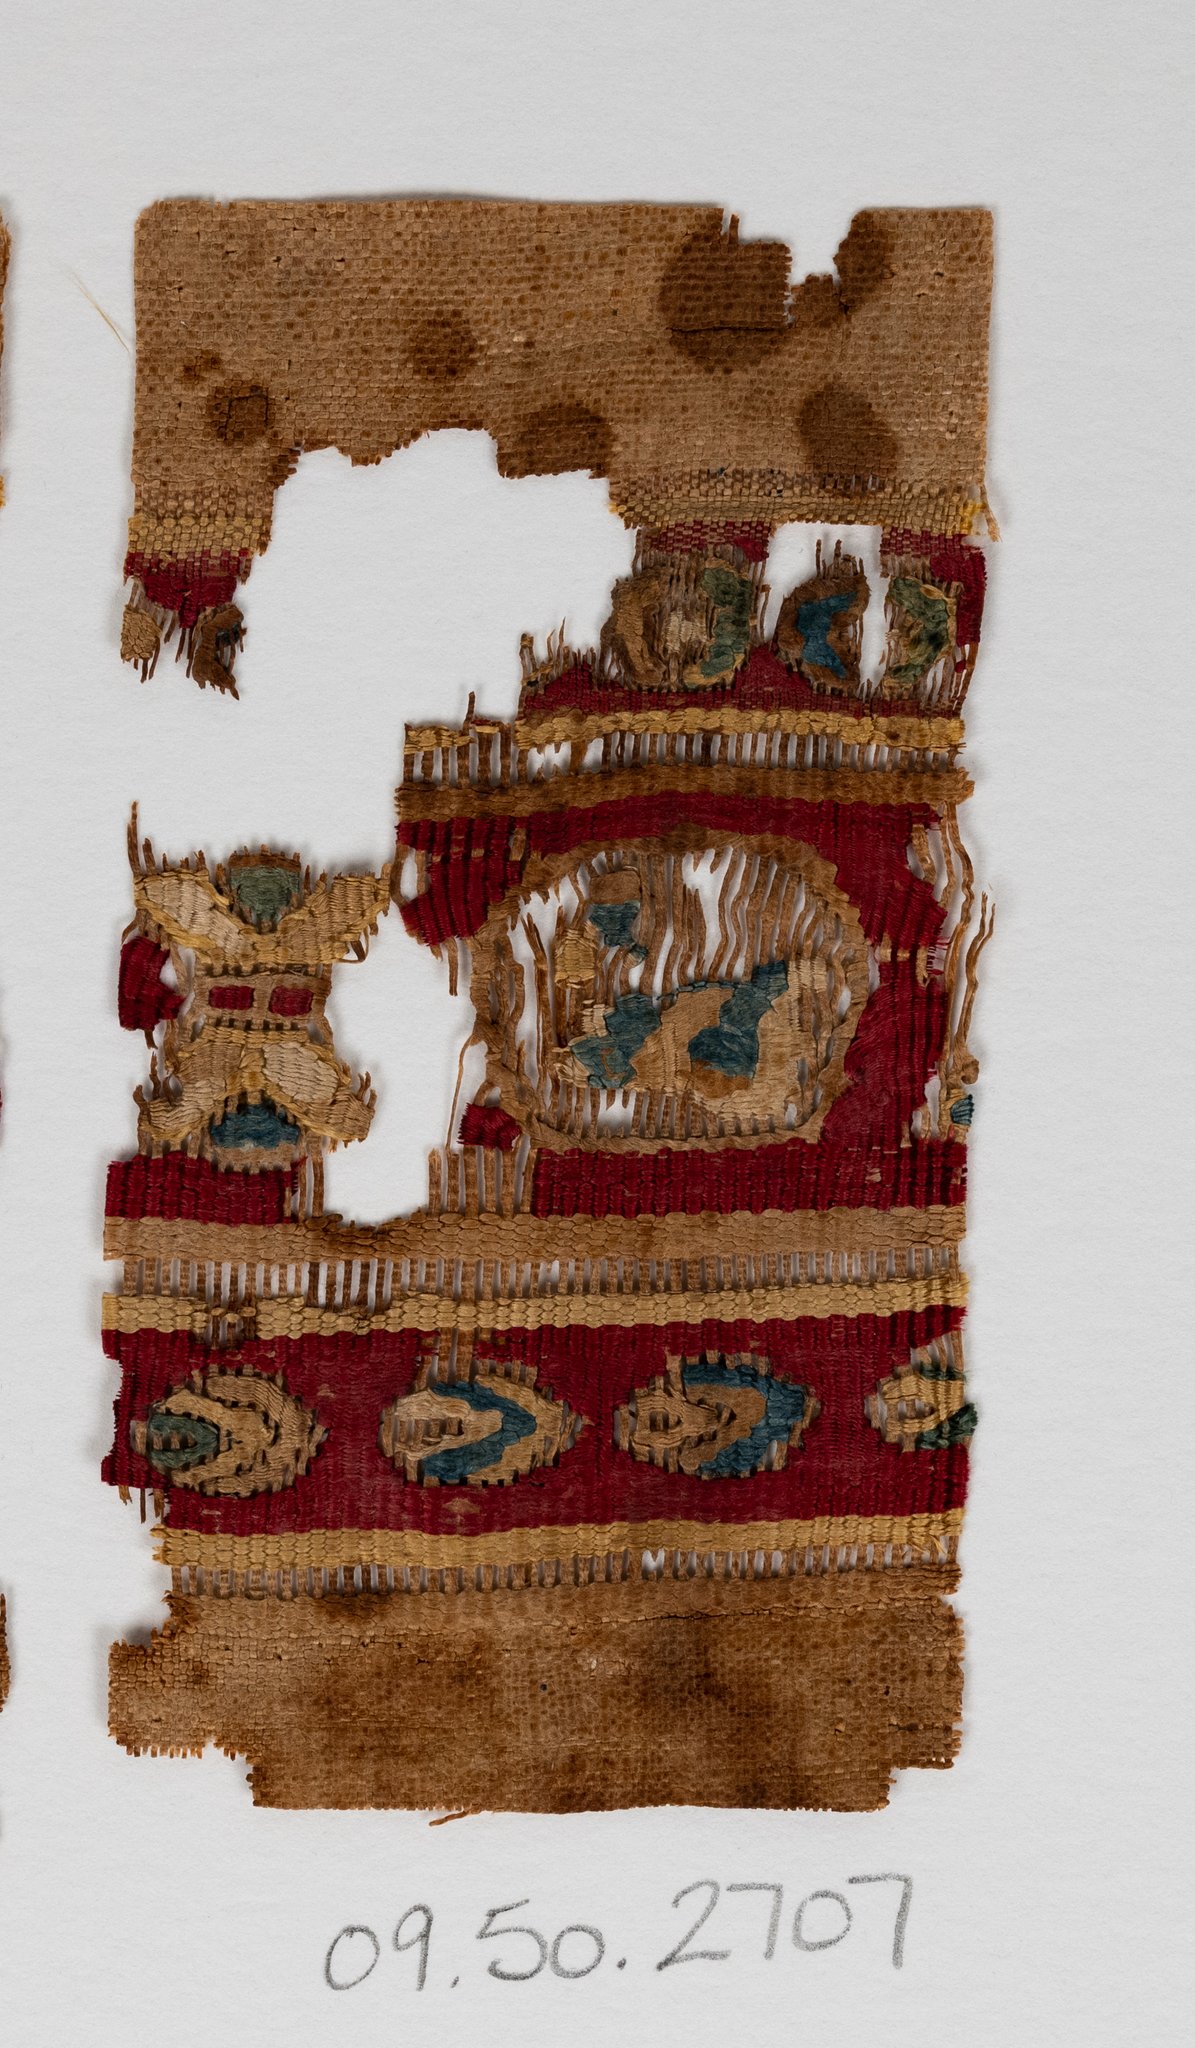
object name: fragment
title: Textile Fragment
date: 701-900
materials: linen, silk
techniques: weave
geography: egypt